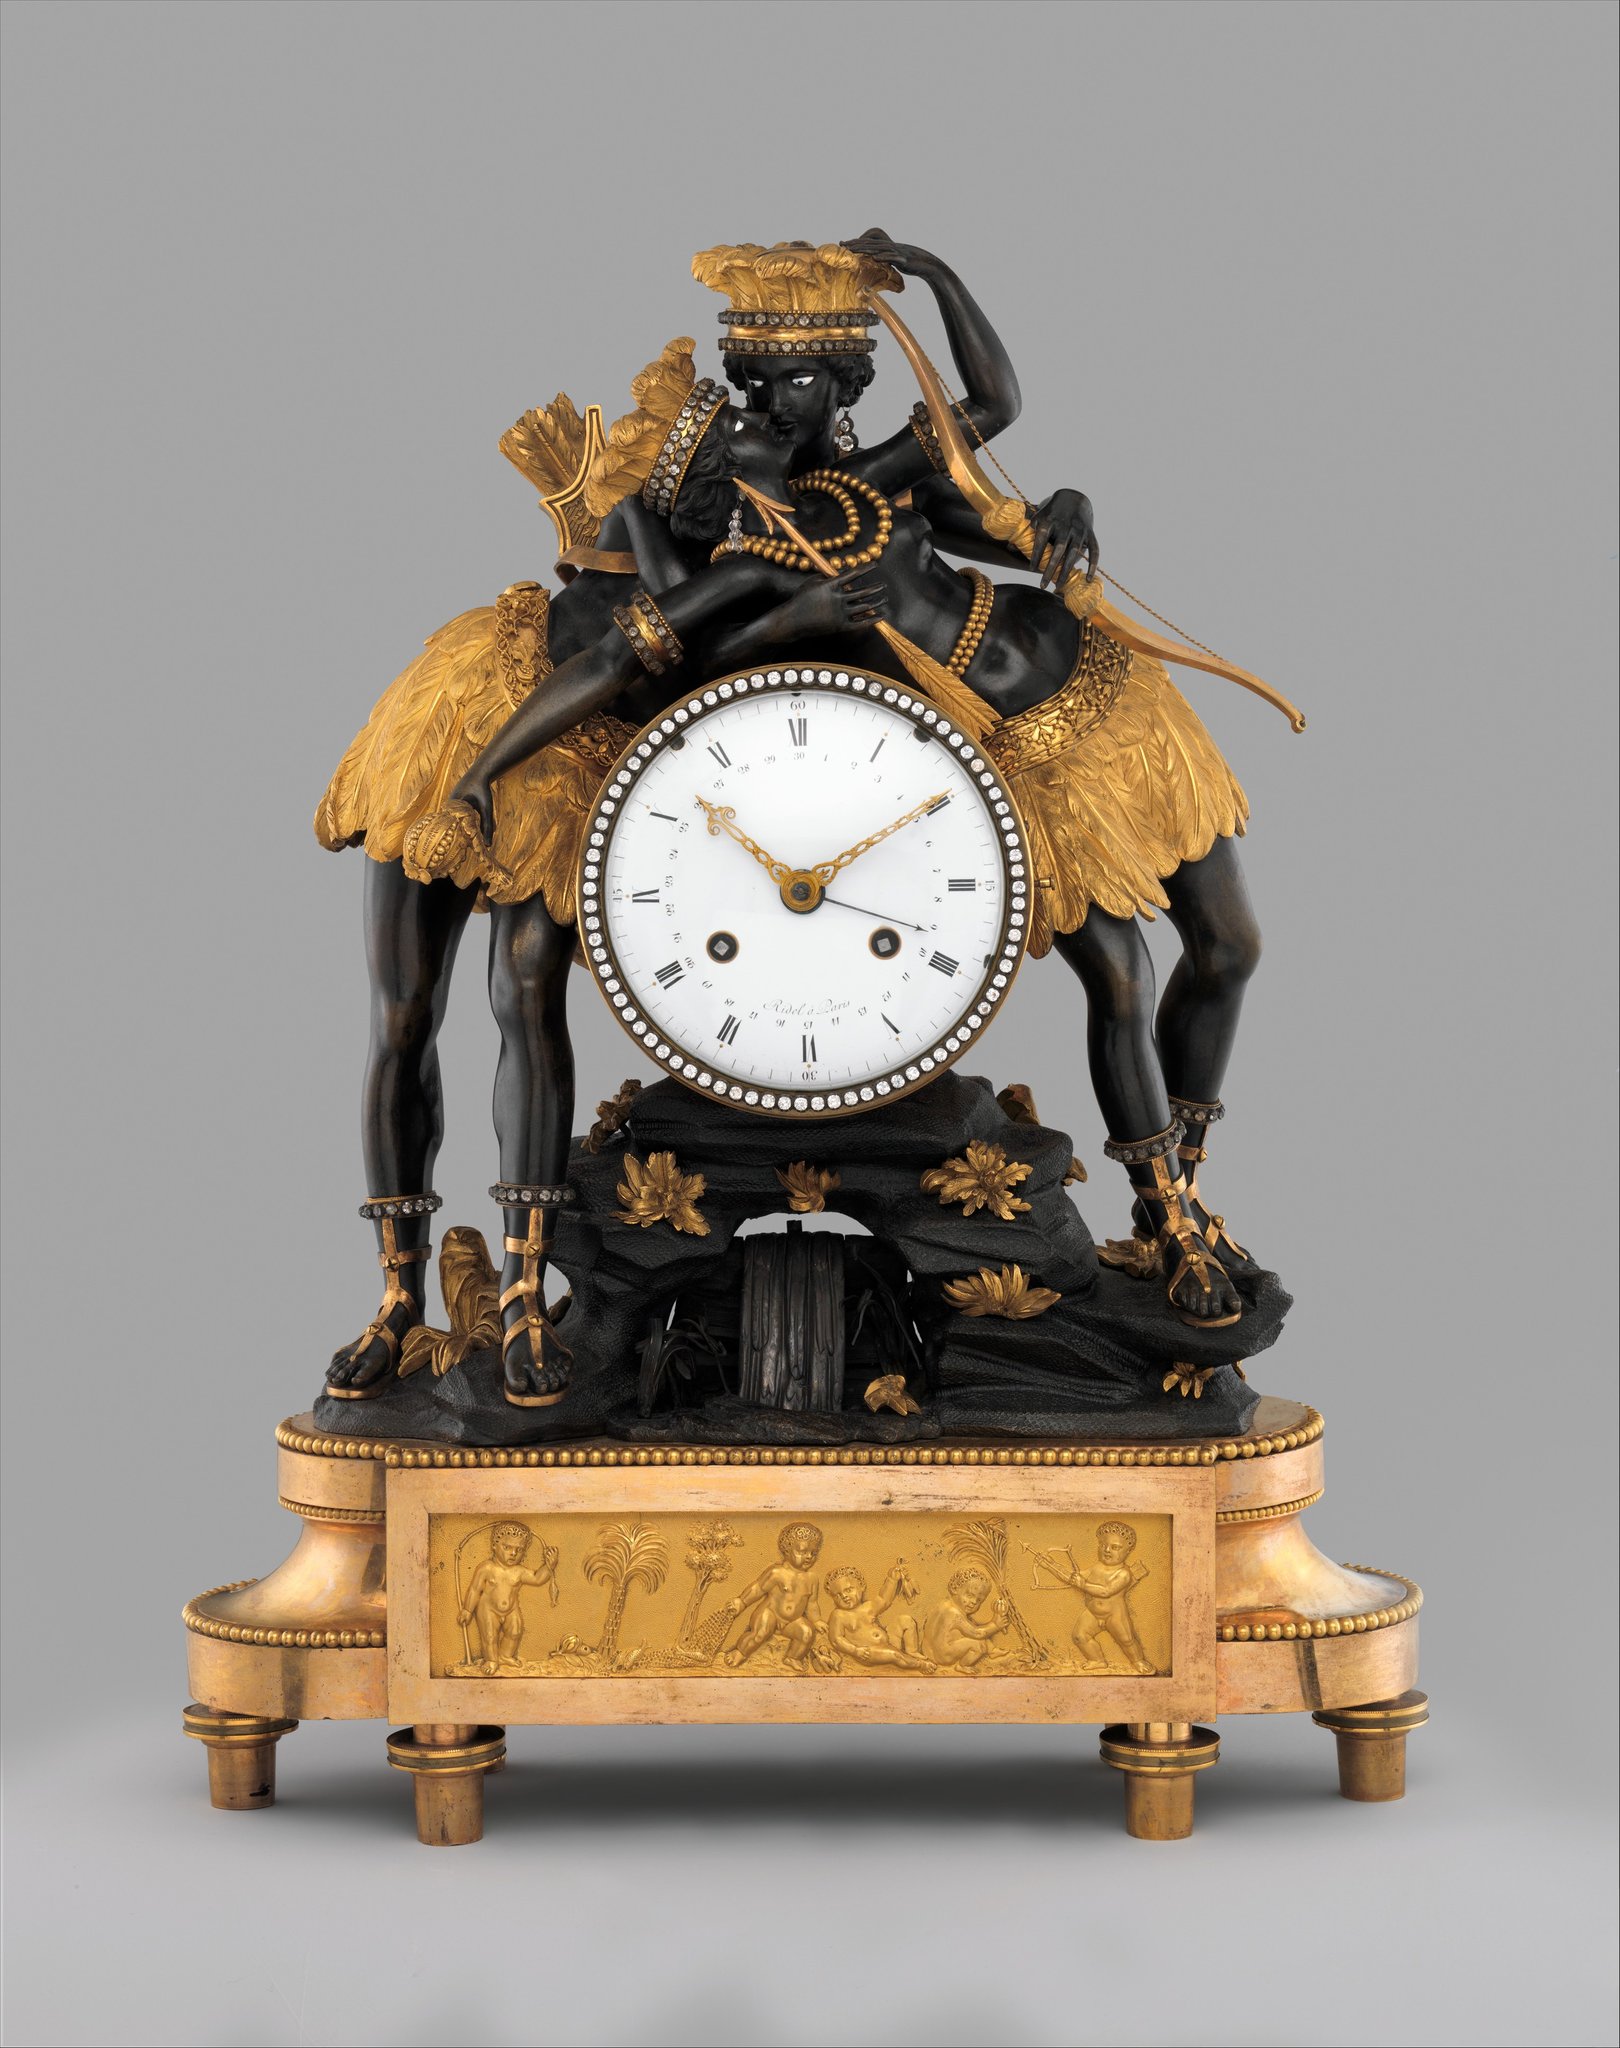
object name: clock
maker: laurent ridel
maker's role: maker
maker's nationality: french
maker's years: 1789-1800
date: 1800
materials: brass, bronze, enamel, gilt brass, paste, steel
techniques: gilding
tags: bow and arrow,boys,men,women